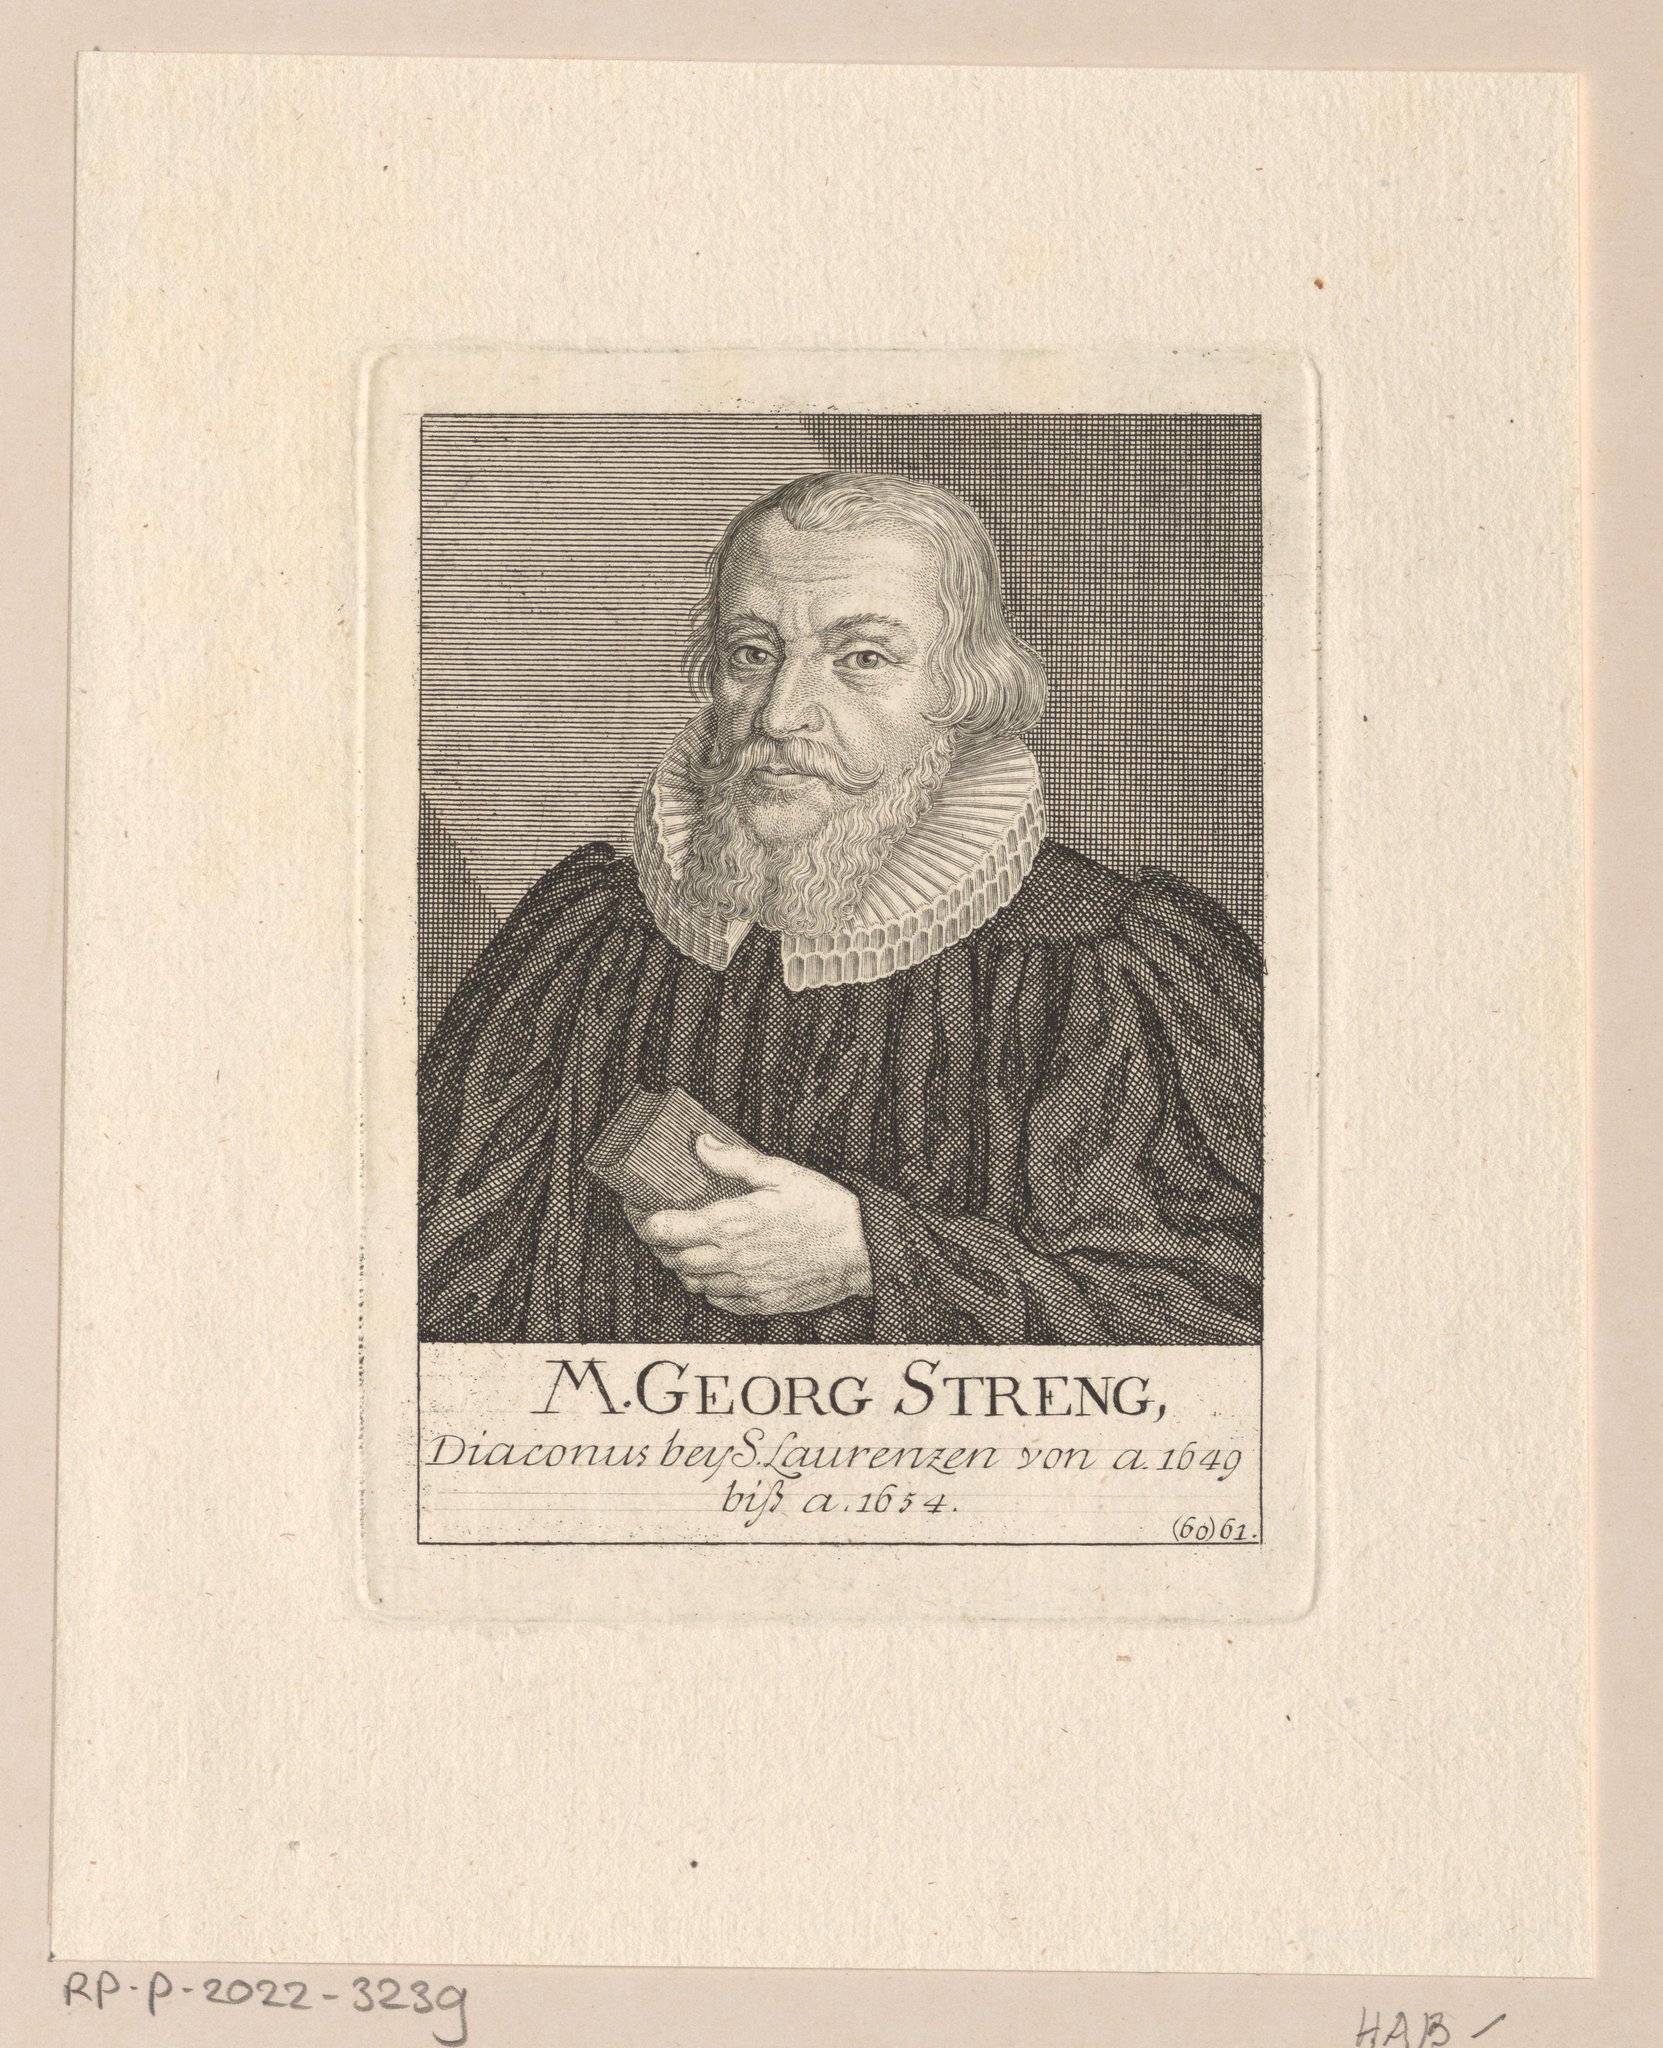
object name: print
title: Portret van Georg Streng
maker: Anonymous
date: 1756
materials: paper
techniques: engraving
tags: functionaries and dignitaries (with name) ~ episcopal protestant churches, historical persons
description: Prent uit: Würfel, Andreas. Diptycha ecclesiae Laurentianae (...). Neurenberg: Christoph Melchior Roth, 1756.